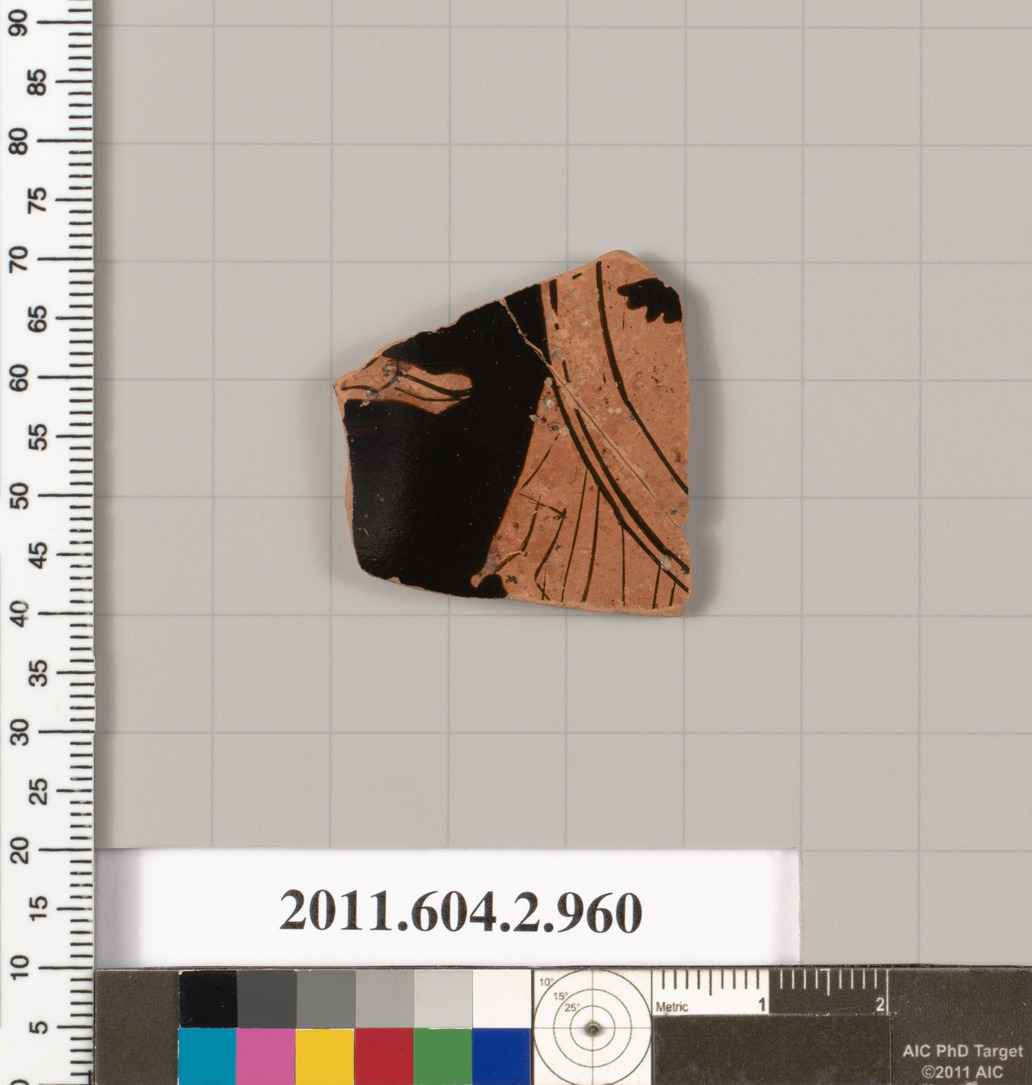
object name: oinochoe fragment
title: Terracotta fragment of an oinochoe (jug)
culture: greek, attic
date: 475-451 BCE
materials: terracotta